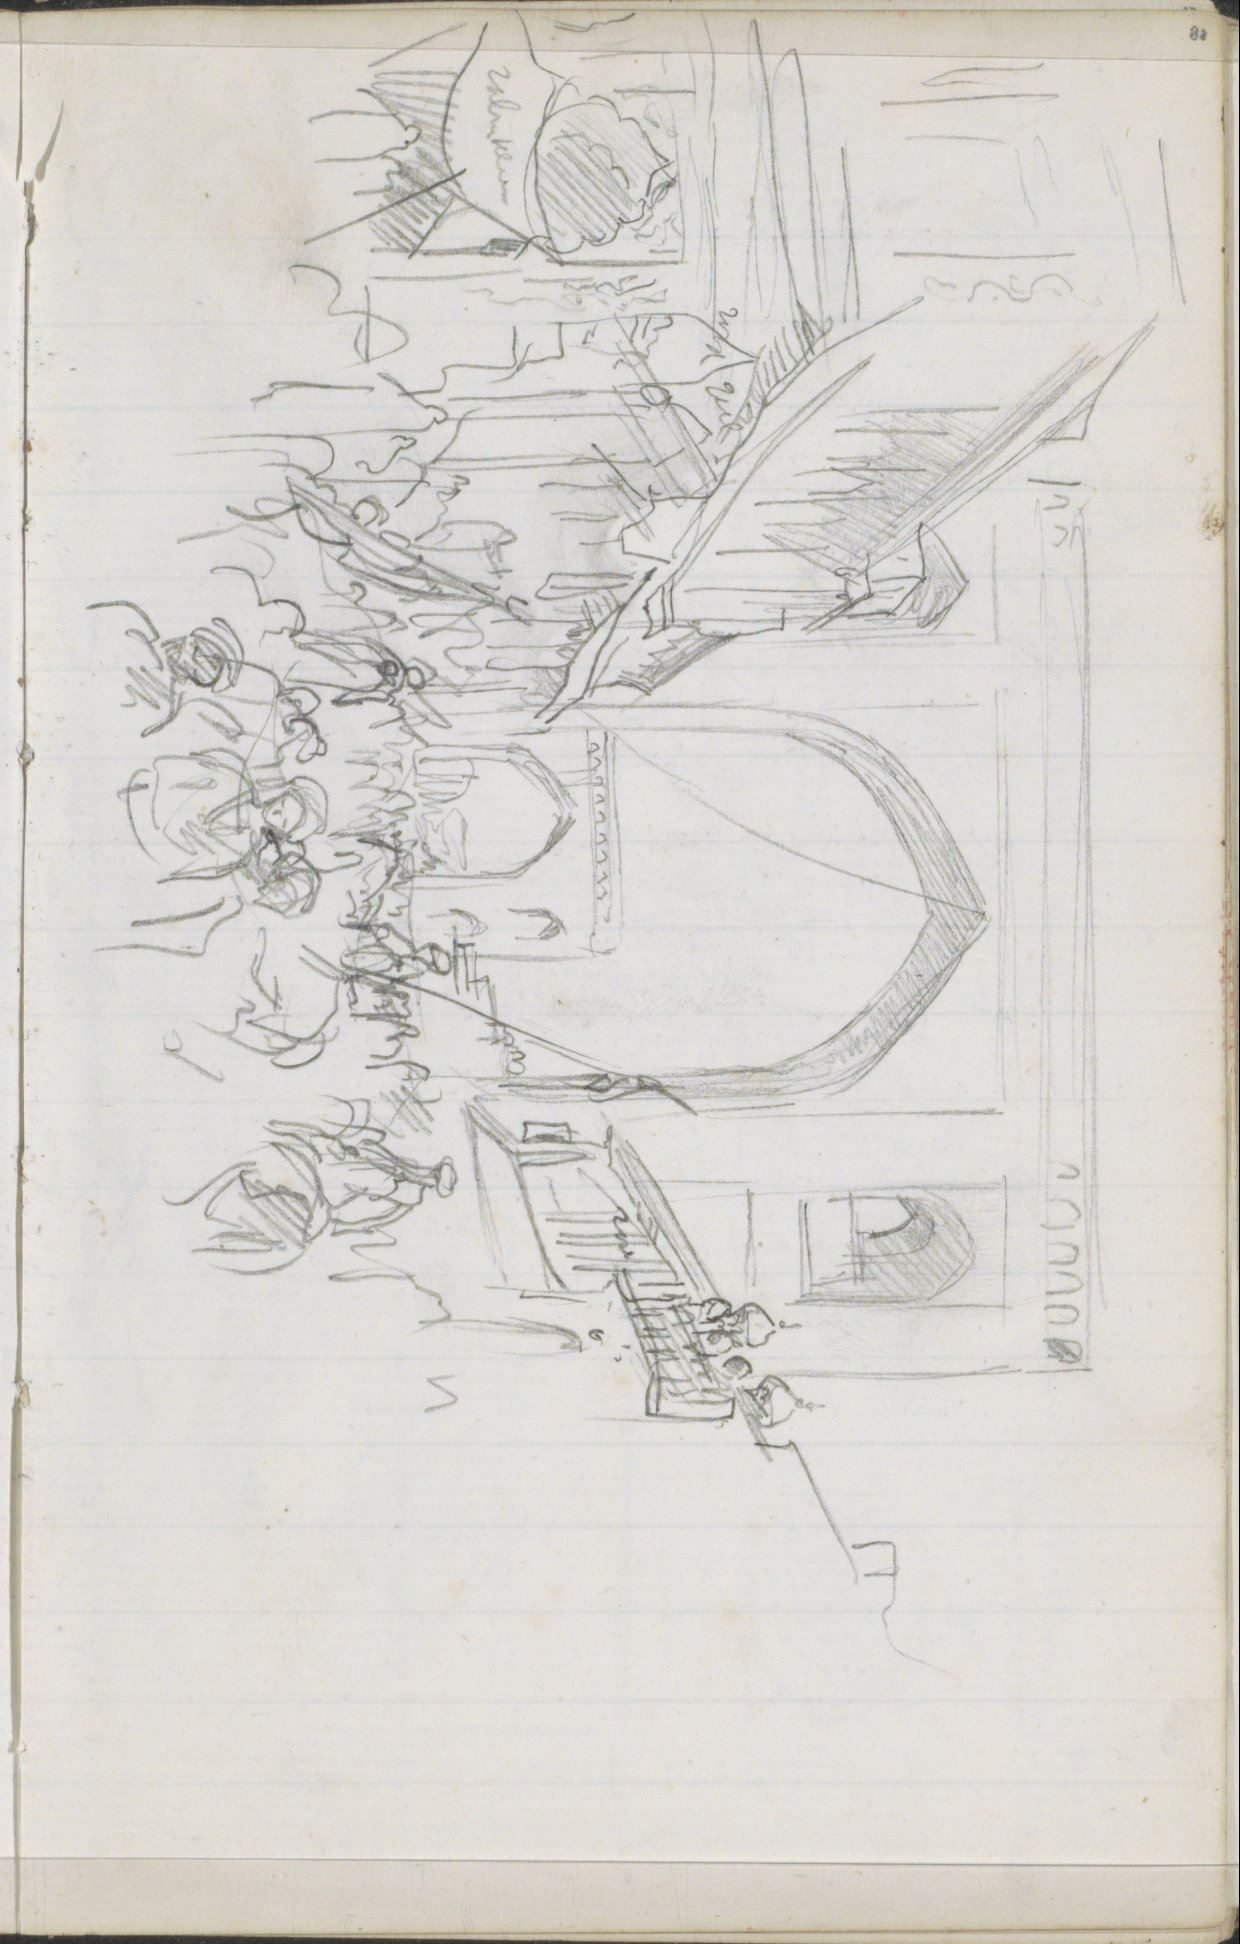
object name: sketchbook leaf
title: Straat met een poort in Hyderabad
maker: marius bauer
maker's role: draughtsman, print maker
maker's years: 1867-1932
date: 1897-1898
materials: pencil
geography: hyderabad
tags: riding a horse, ass, or mule; rider, horseman, arch, archivolt ~ architecture, street (+ city(-scape) with figures, staffage)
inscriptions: kleurnotitie, handgeschreven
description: Pagina 88 uit een schetsboek met 62 bladen.